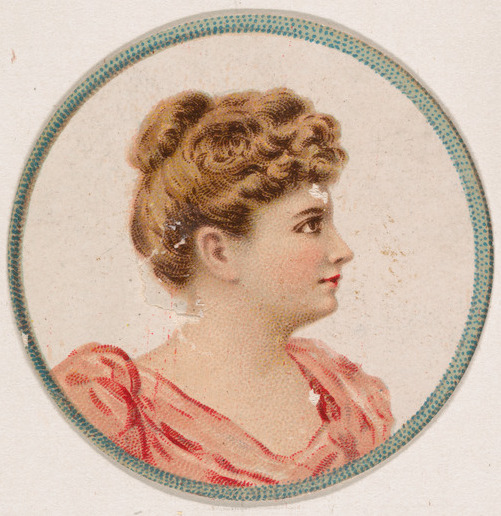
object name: print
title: Portrait of woman, from the Novelties series (N228, Type 2) issued by Kinney Bros.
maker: kinney brothers tobacco company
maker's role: publisher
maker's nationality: american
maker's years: 1869-2011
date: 1889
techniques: color lithograph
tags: profiles,women